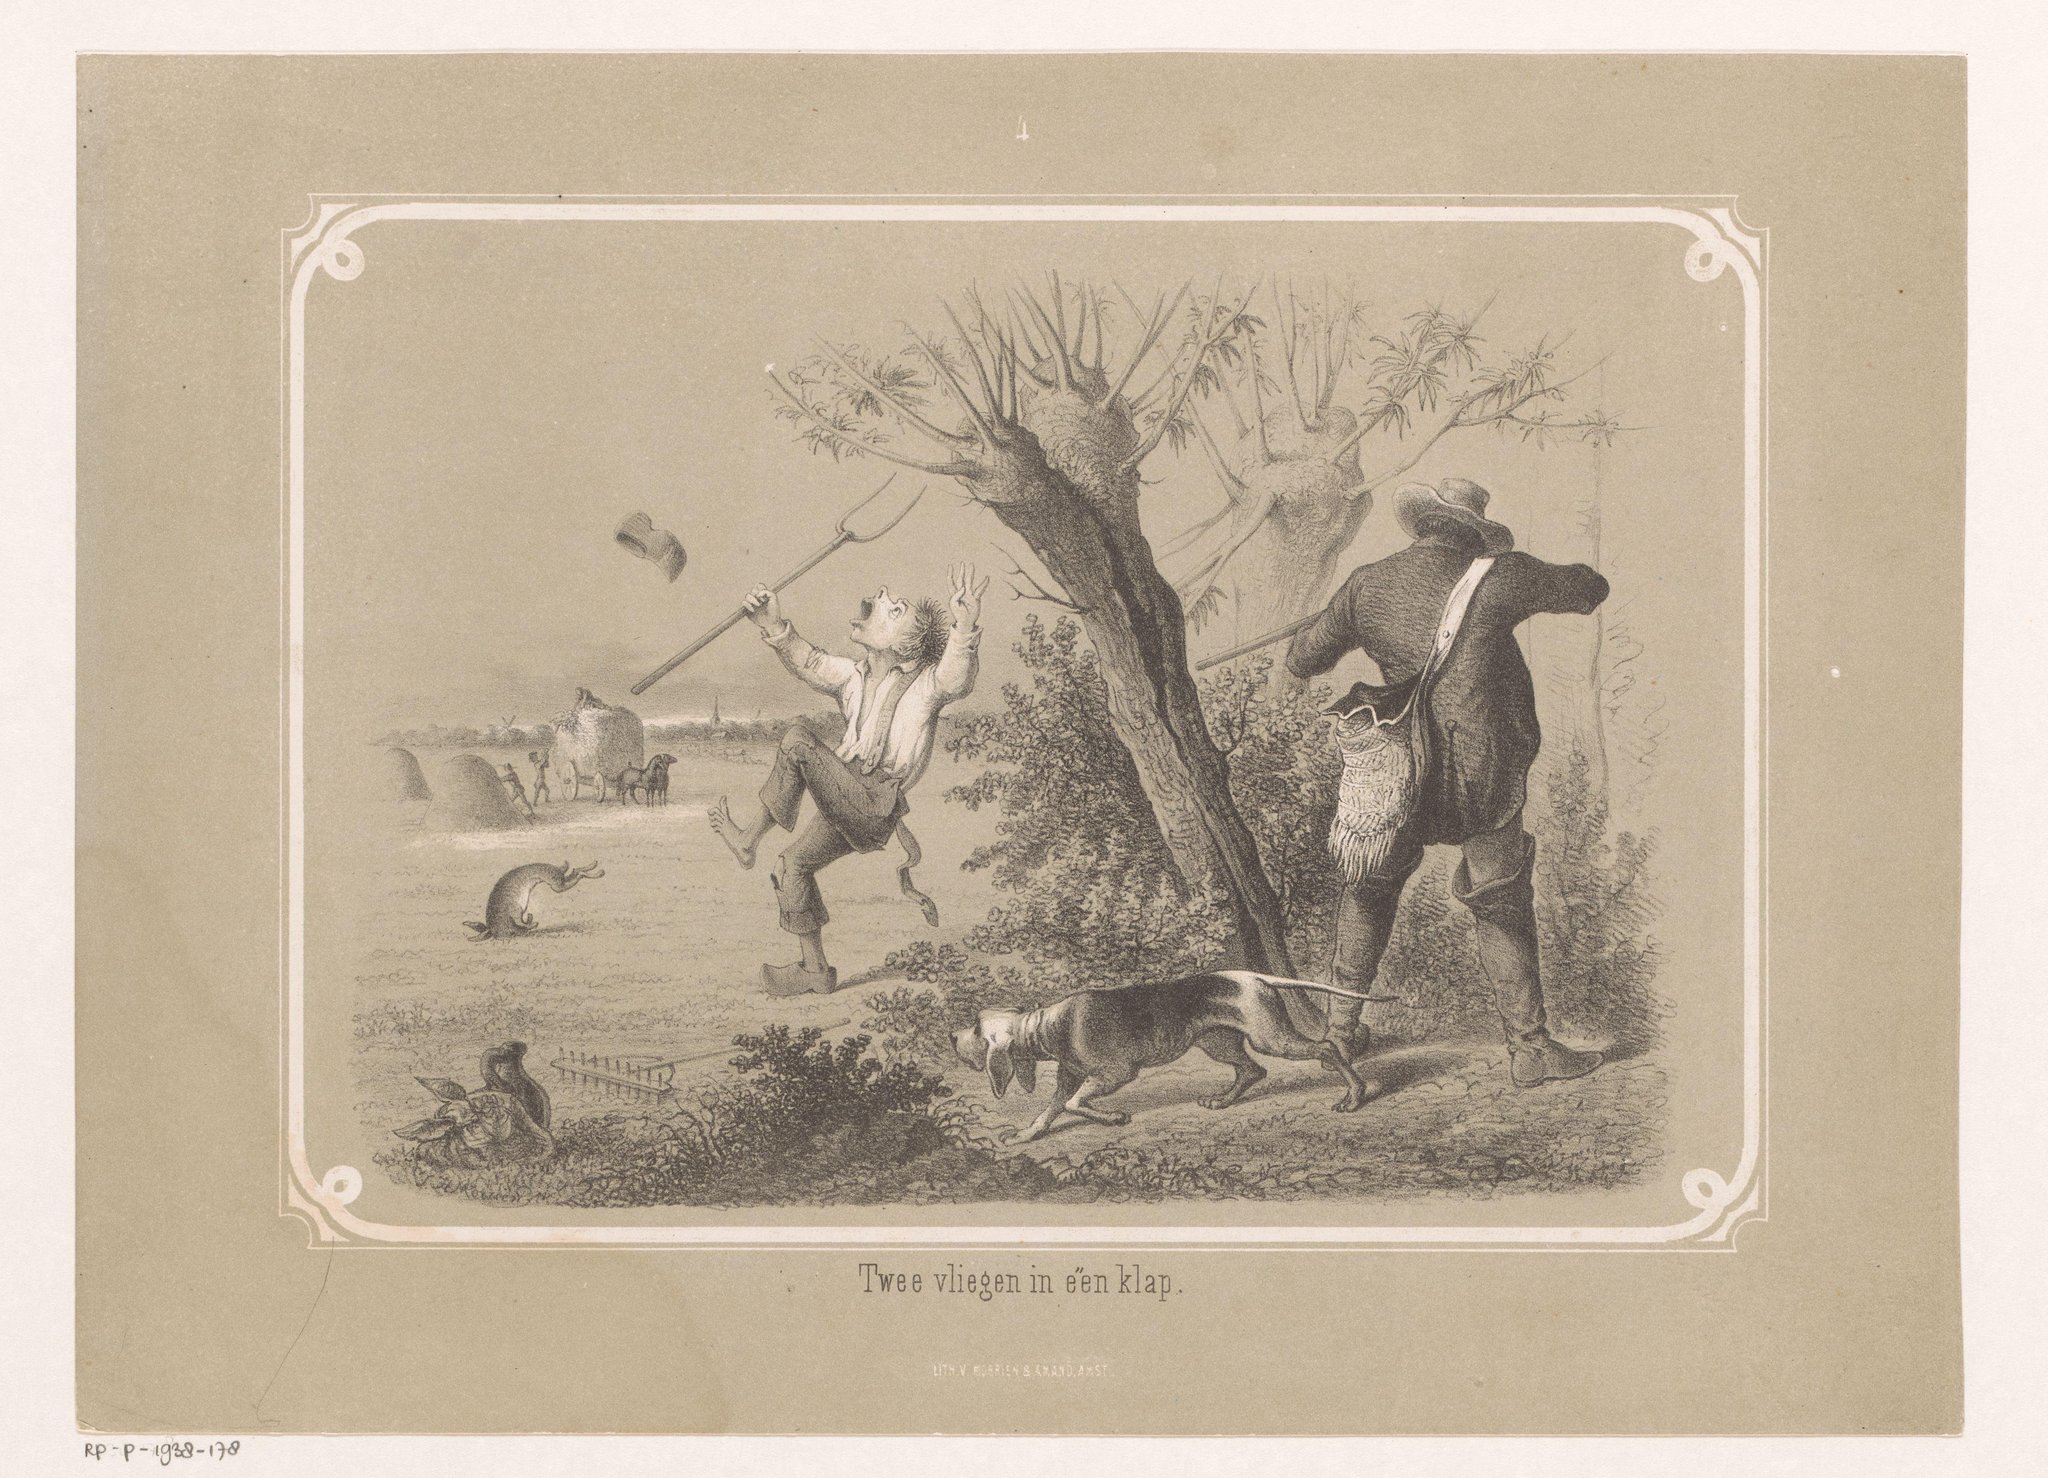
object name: print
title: Jager schiet haas en boer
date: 1865-1866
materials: paper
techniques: tone lithography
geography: amsterdam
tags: harvest, agricultural products and by-products: hay, hunter, rodents: hare, farmers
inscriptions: collector's mark: Lugt 2228, collector's mark: Lugt 2760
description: Verbeelding van het spreekwoord: twee vliegen in een klap slaan. Een jager, verscholen in de struiken, schiet een haas aan. Met hetzelfde schot raakt hij een boerenknecht die zich schuilhield. Op het land zijn boeren bezig met hooien.